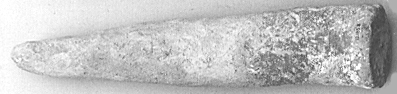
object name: cone, uninscribed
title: Funerary cone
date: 2124-1981 BCE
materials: paint, pottery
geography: egypt